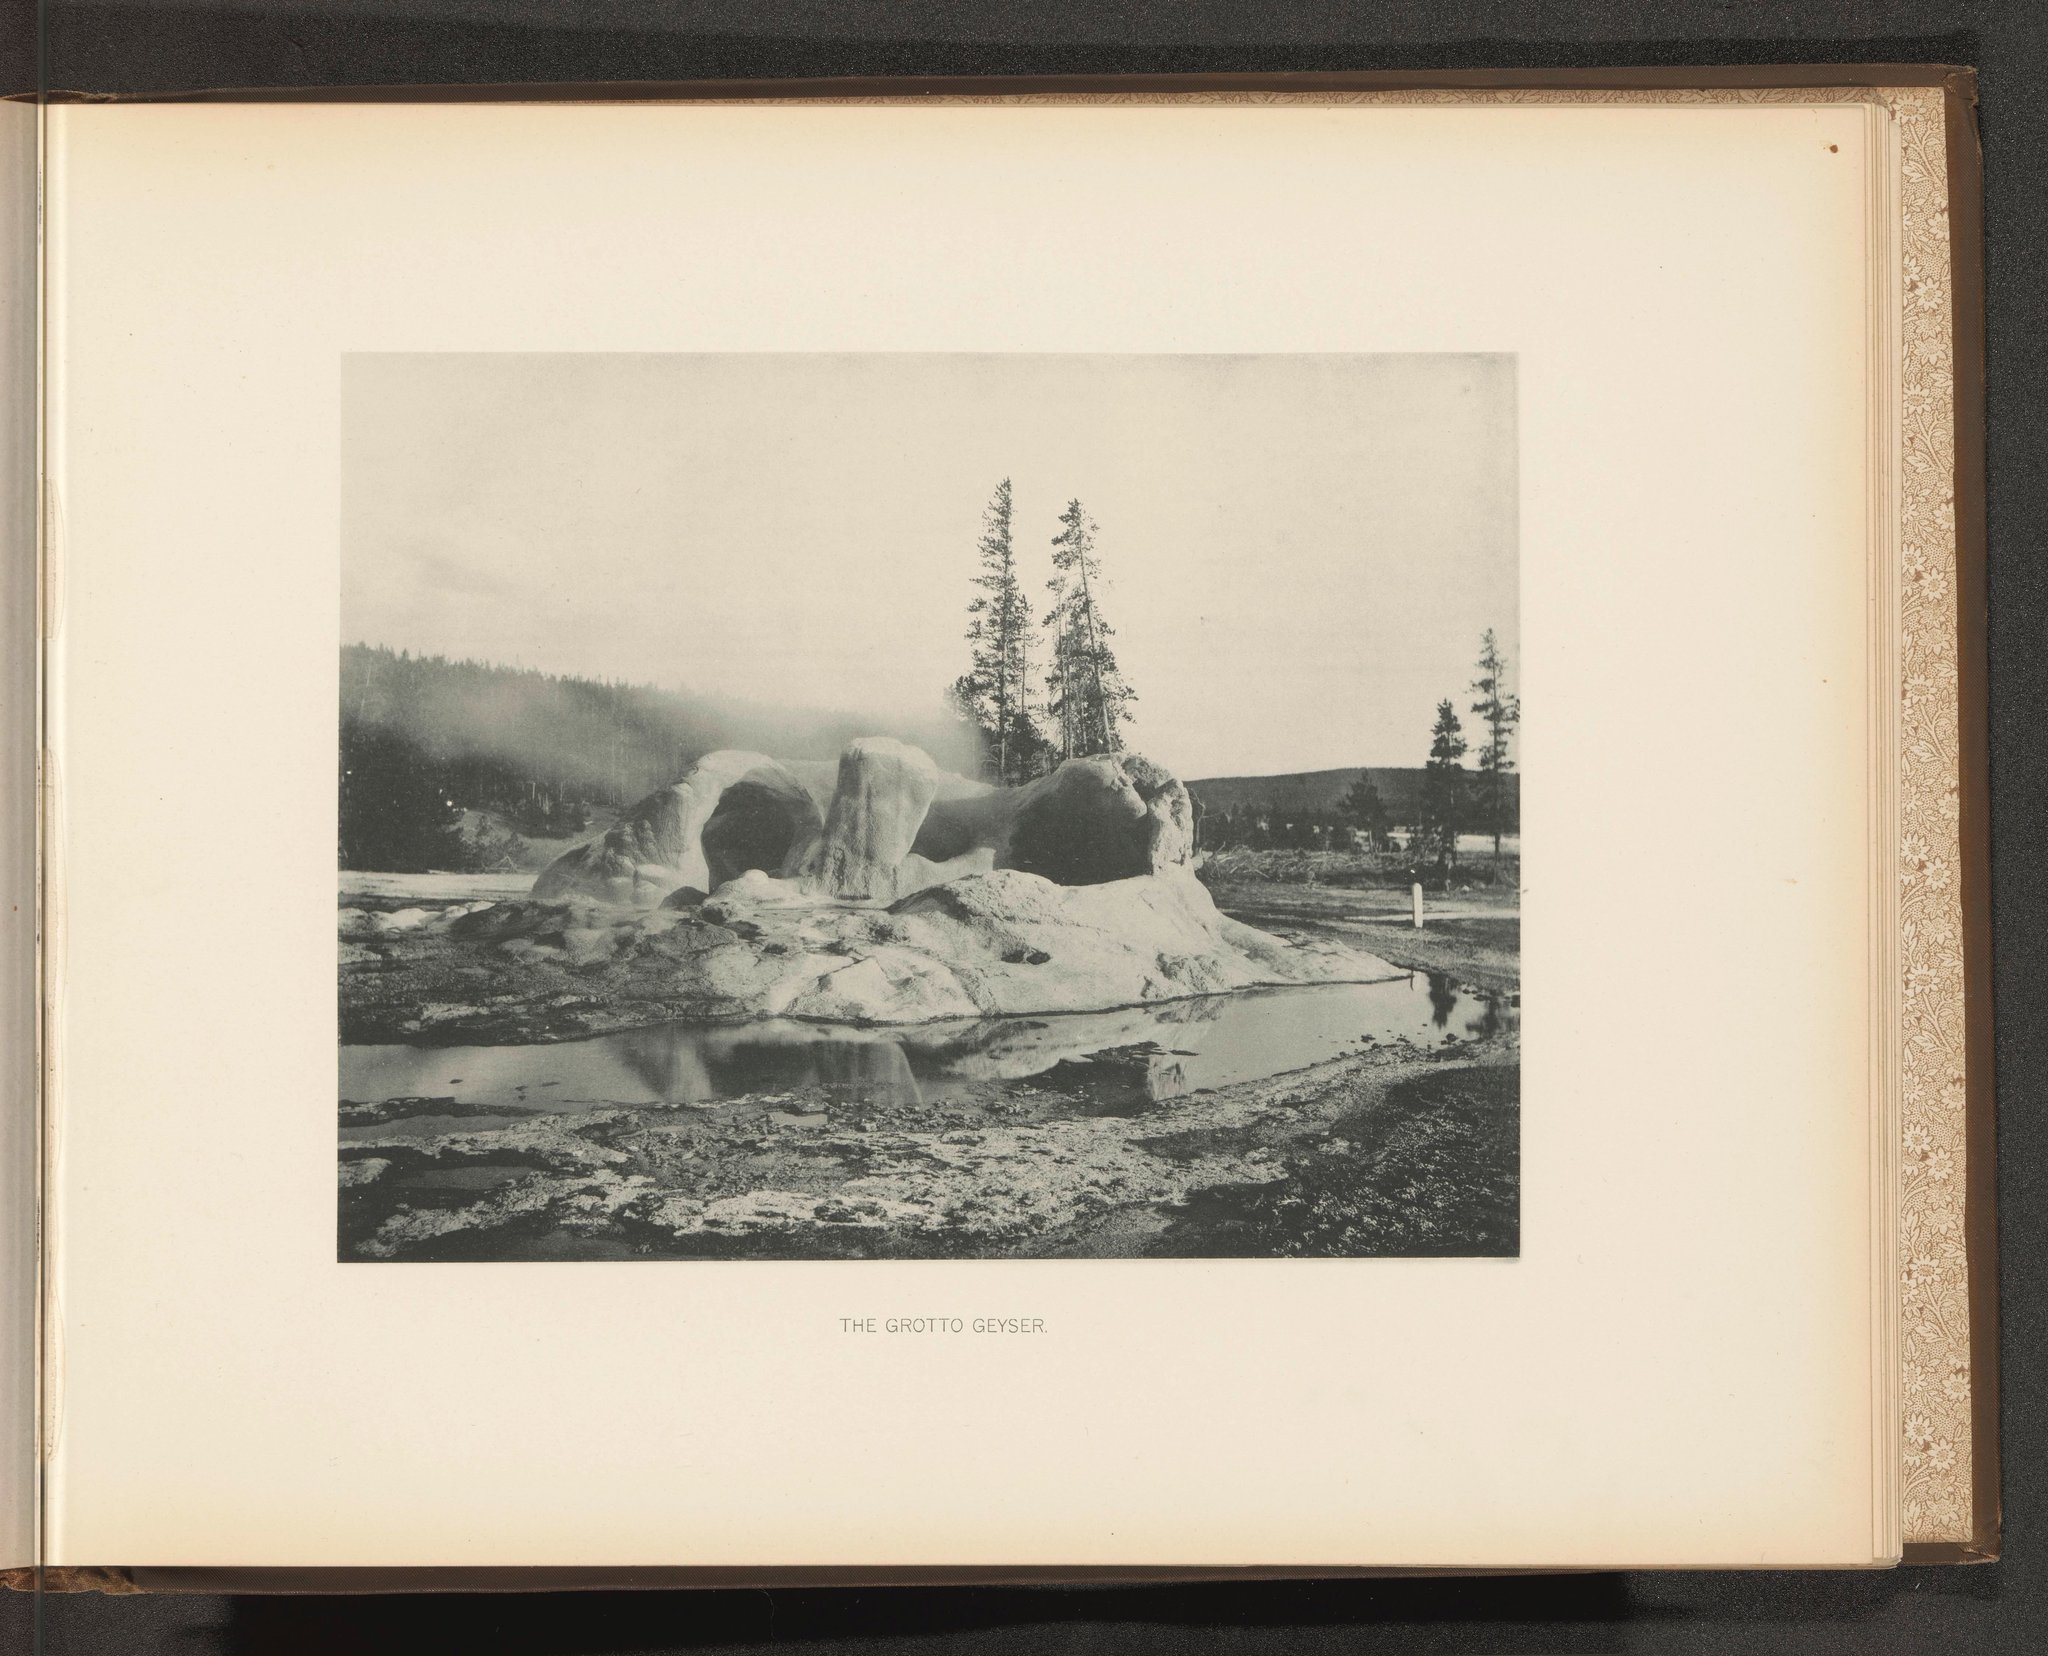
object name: page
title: The Grotto Geyser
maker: frank jay haynes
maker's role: fotograaf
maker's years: 1853-1921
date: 1886-1891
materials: paper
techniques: photograph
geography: new york city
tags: hot spring, geyser